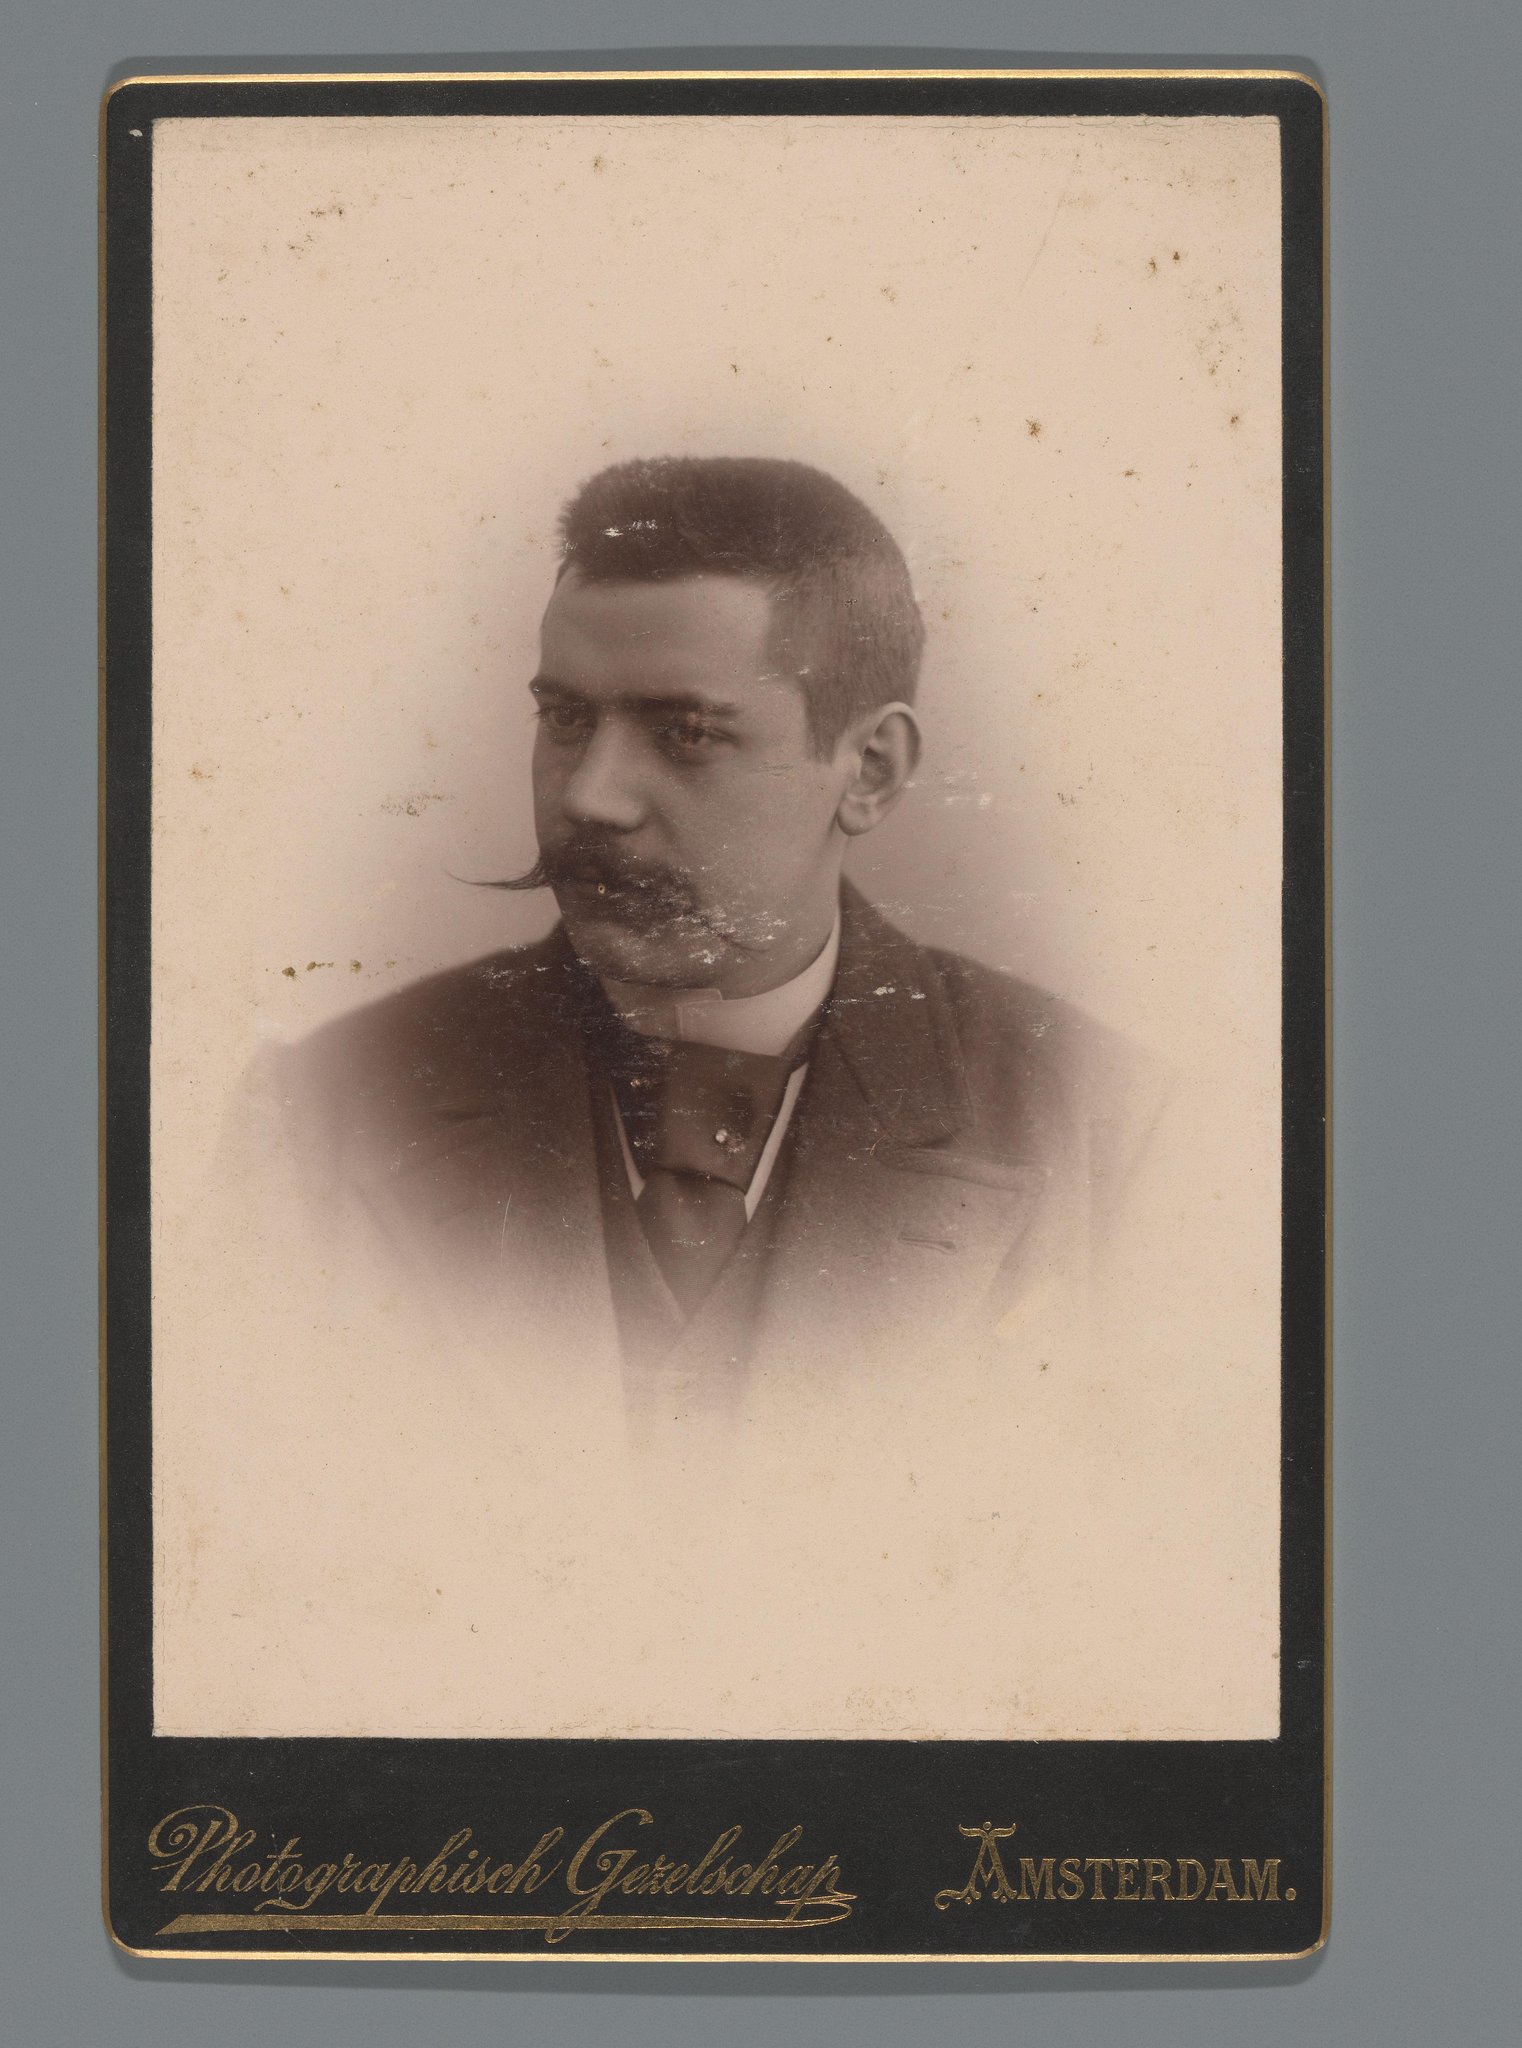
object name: cabinet photograph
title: Portret van een onbekende man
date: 1891-1910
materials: paper, cardboard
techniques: collodion silver print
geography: amsterdam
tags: anonymous historical person portrayed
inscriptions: address: ‘Singel 470,/ tusschen Odéon en Koningsplein,/ tegenover den Heiligenweg/ Amsterdam.’